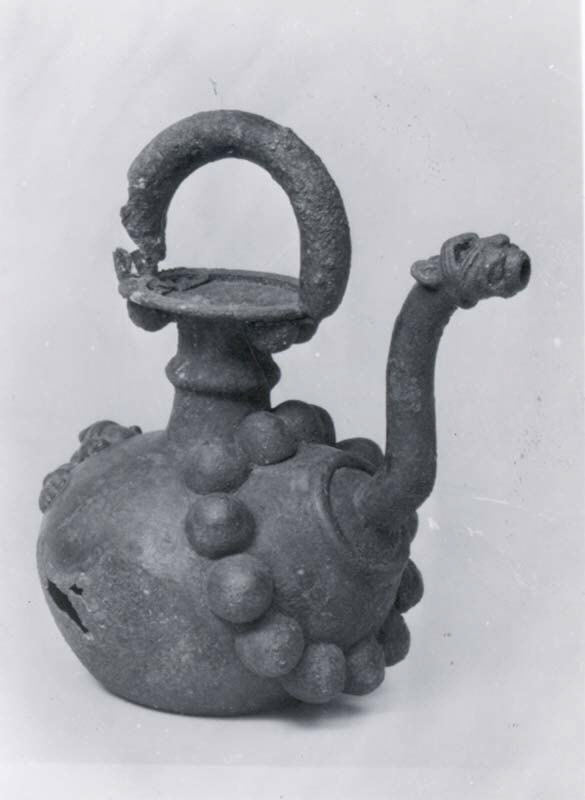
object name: vessel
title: Spouted vessel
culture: iranian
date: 900-701 BCE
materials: bronze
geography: western iran